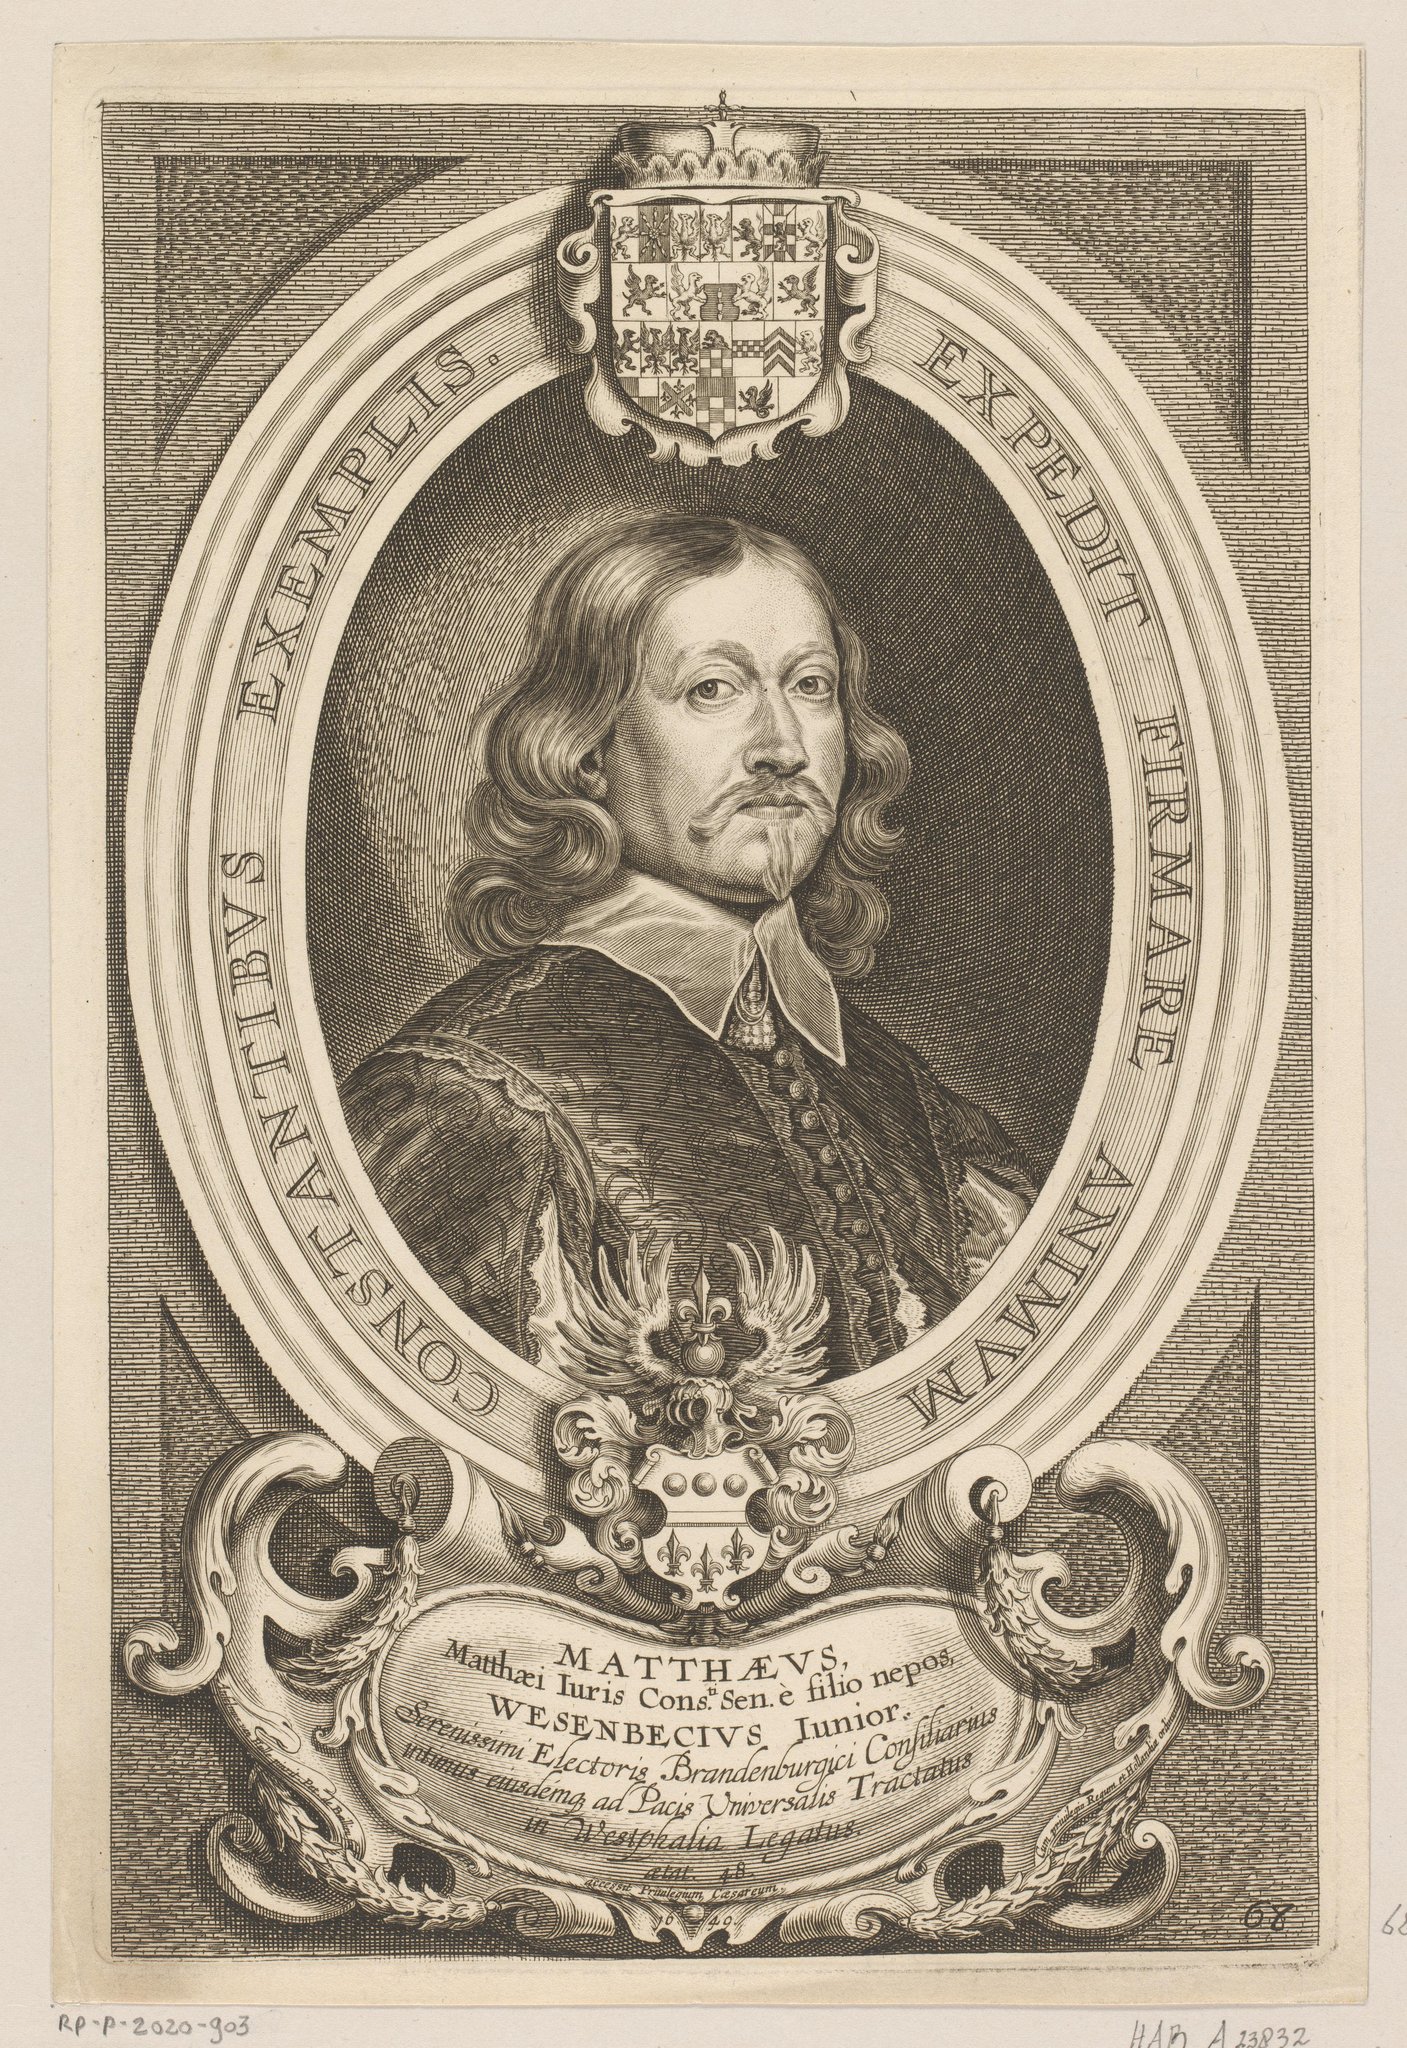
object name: print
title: Portret van Mathaeus von Wesenbeck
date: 1697-1717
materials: paper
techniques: engraving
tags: westphalia, official; civil servant; functionary (in general), historical persons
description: Prent is gebruikt in verschillende series. De huidige staat is gebruikt in de hieronder vermelde serie en uitgaven (6), (7) en (8). (1)'Icones legatorum (...)', uitgegeven door Daniel Middeler in 1648 in Antwerpen. (2)‘Legati Celeberrimi’, uitgegeven door Daniel Middeler in 1648 in Antwerpen. (3)‘Legati Celeberrimi’, waarschijnlijk uitgegeven in 1651, maar opnieuw met de vermelding door Daniel Middeler in 1648 in Antwerpen. (4)‘Legati Celeberrimi', waarschijnlijk uitgegeven in 1658, maar opnieuw met de vermelding door Daniel Middeler in 1648 in Antwerpen. (5) 'Pacificatores orbis Christiani, sive icones principum, ducum et legatorum, qui Monasterii atque Osnabrugae (...)', uitgegeven door Pieter van der Slaart in 1696 in Rotterdam. (6) 'Pacificatores orbis Christiani, sive icones principum, ducum et legatorum, qui Monasterii atque Osnabrugae (...)', uitgegeven door Pieter van der Slaart in 1697 in Rotterdam. (7) 'Pacificatores orbis Christiani, sive icones principum, ducum et legatorum, qui Monasterii atque Osnabrugae (...)', waarschijnlijk uitgegeven circa 1713, maar opnieuw met vermelding van Pieter van der Slaart in 1697 in Rotterdam. De platen in deze uitgave zijn voor het eerst genummerd. (8) 'Les hommes illustres qui ont vécu dans le XXIIe siècle (...)', uitgegeven door David Mortier in 1717 in Rotterdam. Zie documentatie. Mogelijk zijn er nog meerdere uitgaven en staten van deze prent.